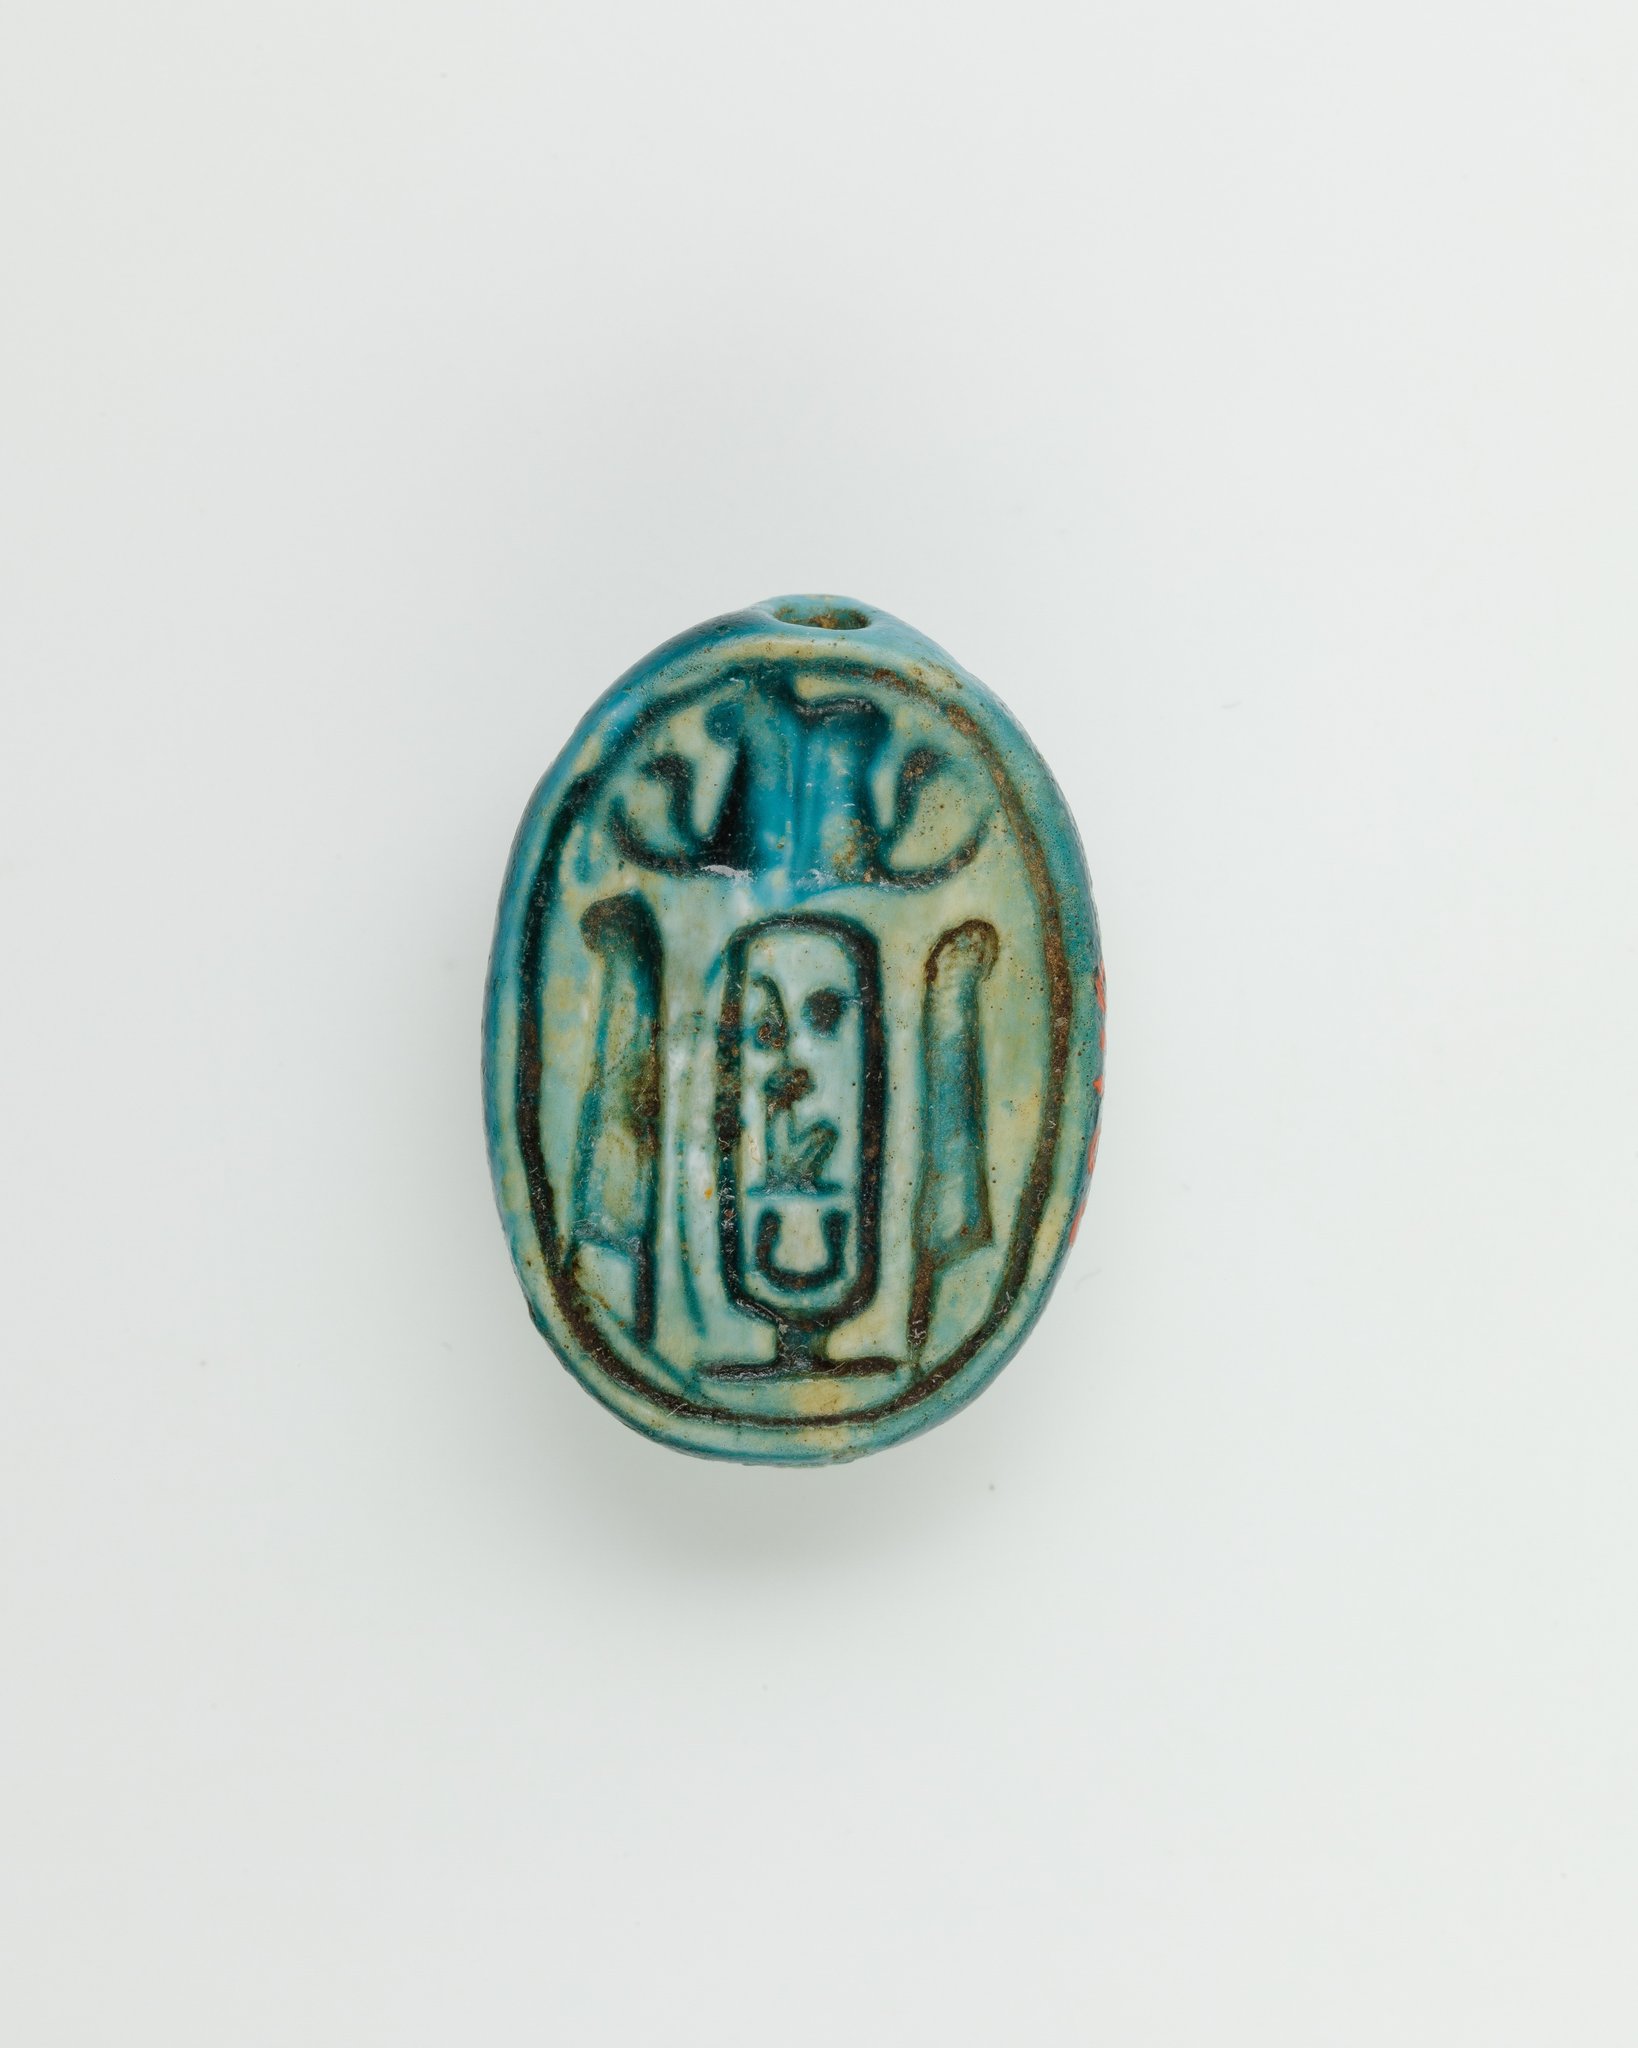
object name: amulet, wedjat eye, maatkare hatshepsut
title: Wedjat-Eye Design Amulet Inscribed With the Cartouche Maatkare (Hatshepsut)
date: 1479-1458 BCE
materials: stone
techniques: glazing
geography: egypt